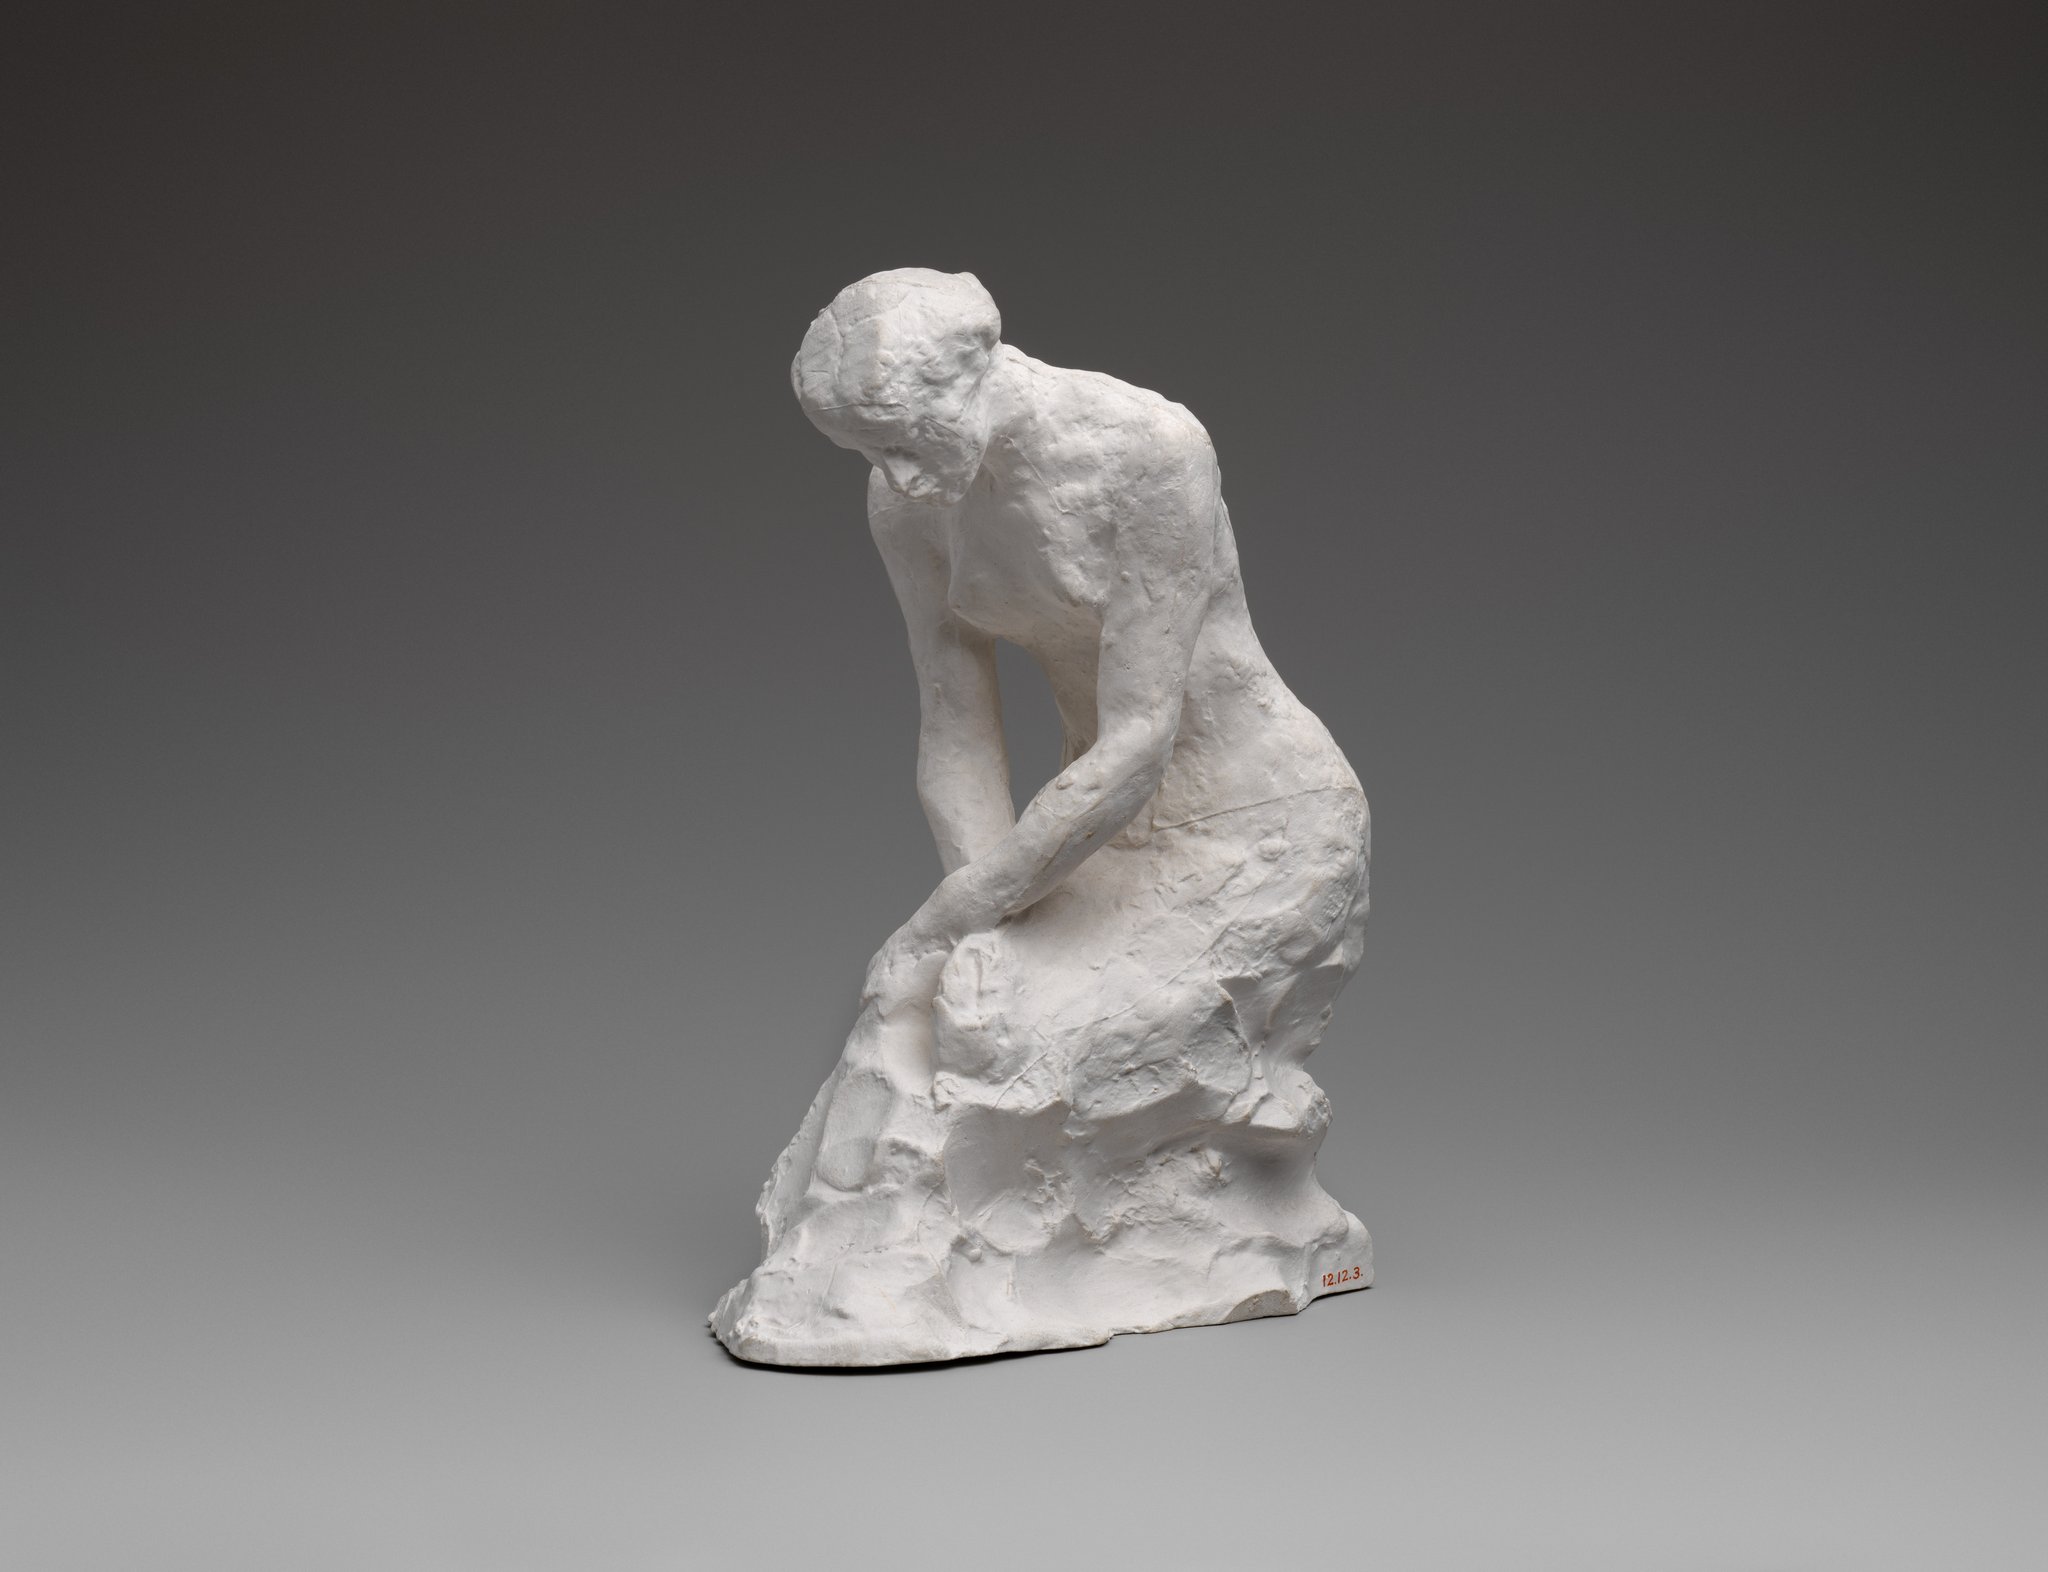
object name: cast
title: Young woman kneeling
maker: auguste rodin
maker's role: artist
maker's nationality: french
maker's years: 1840-1917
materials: plaster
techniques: casting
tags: women